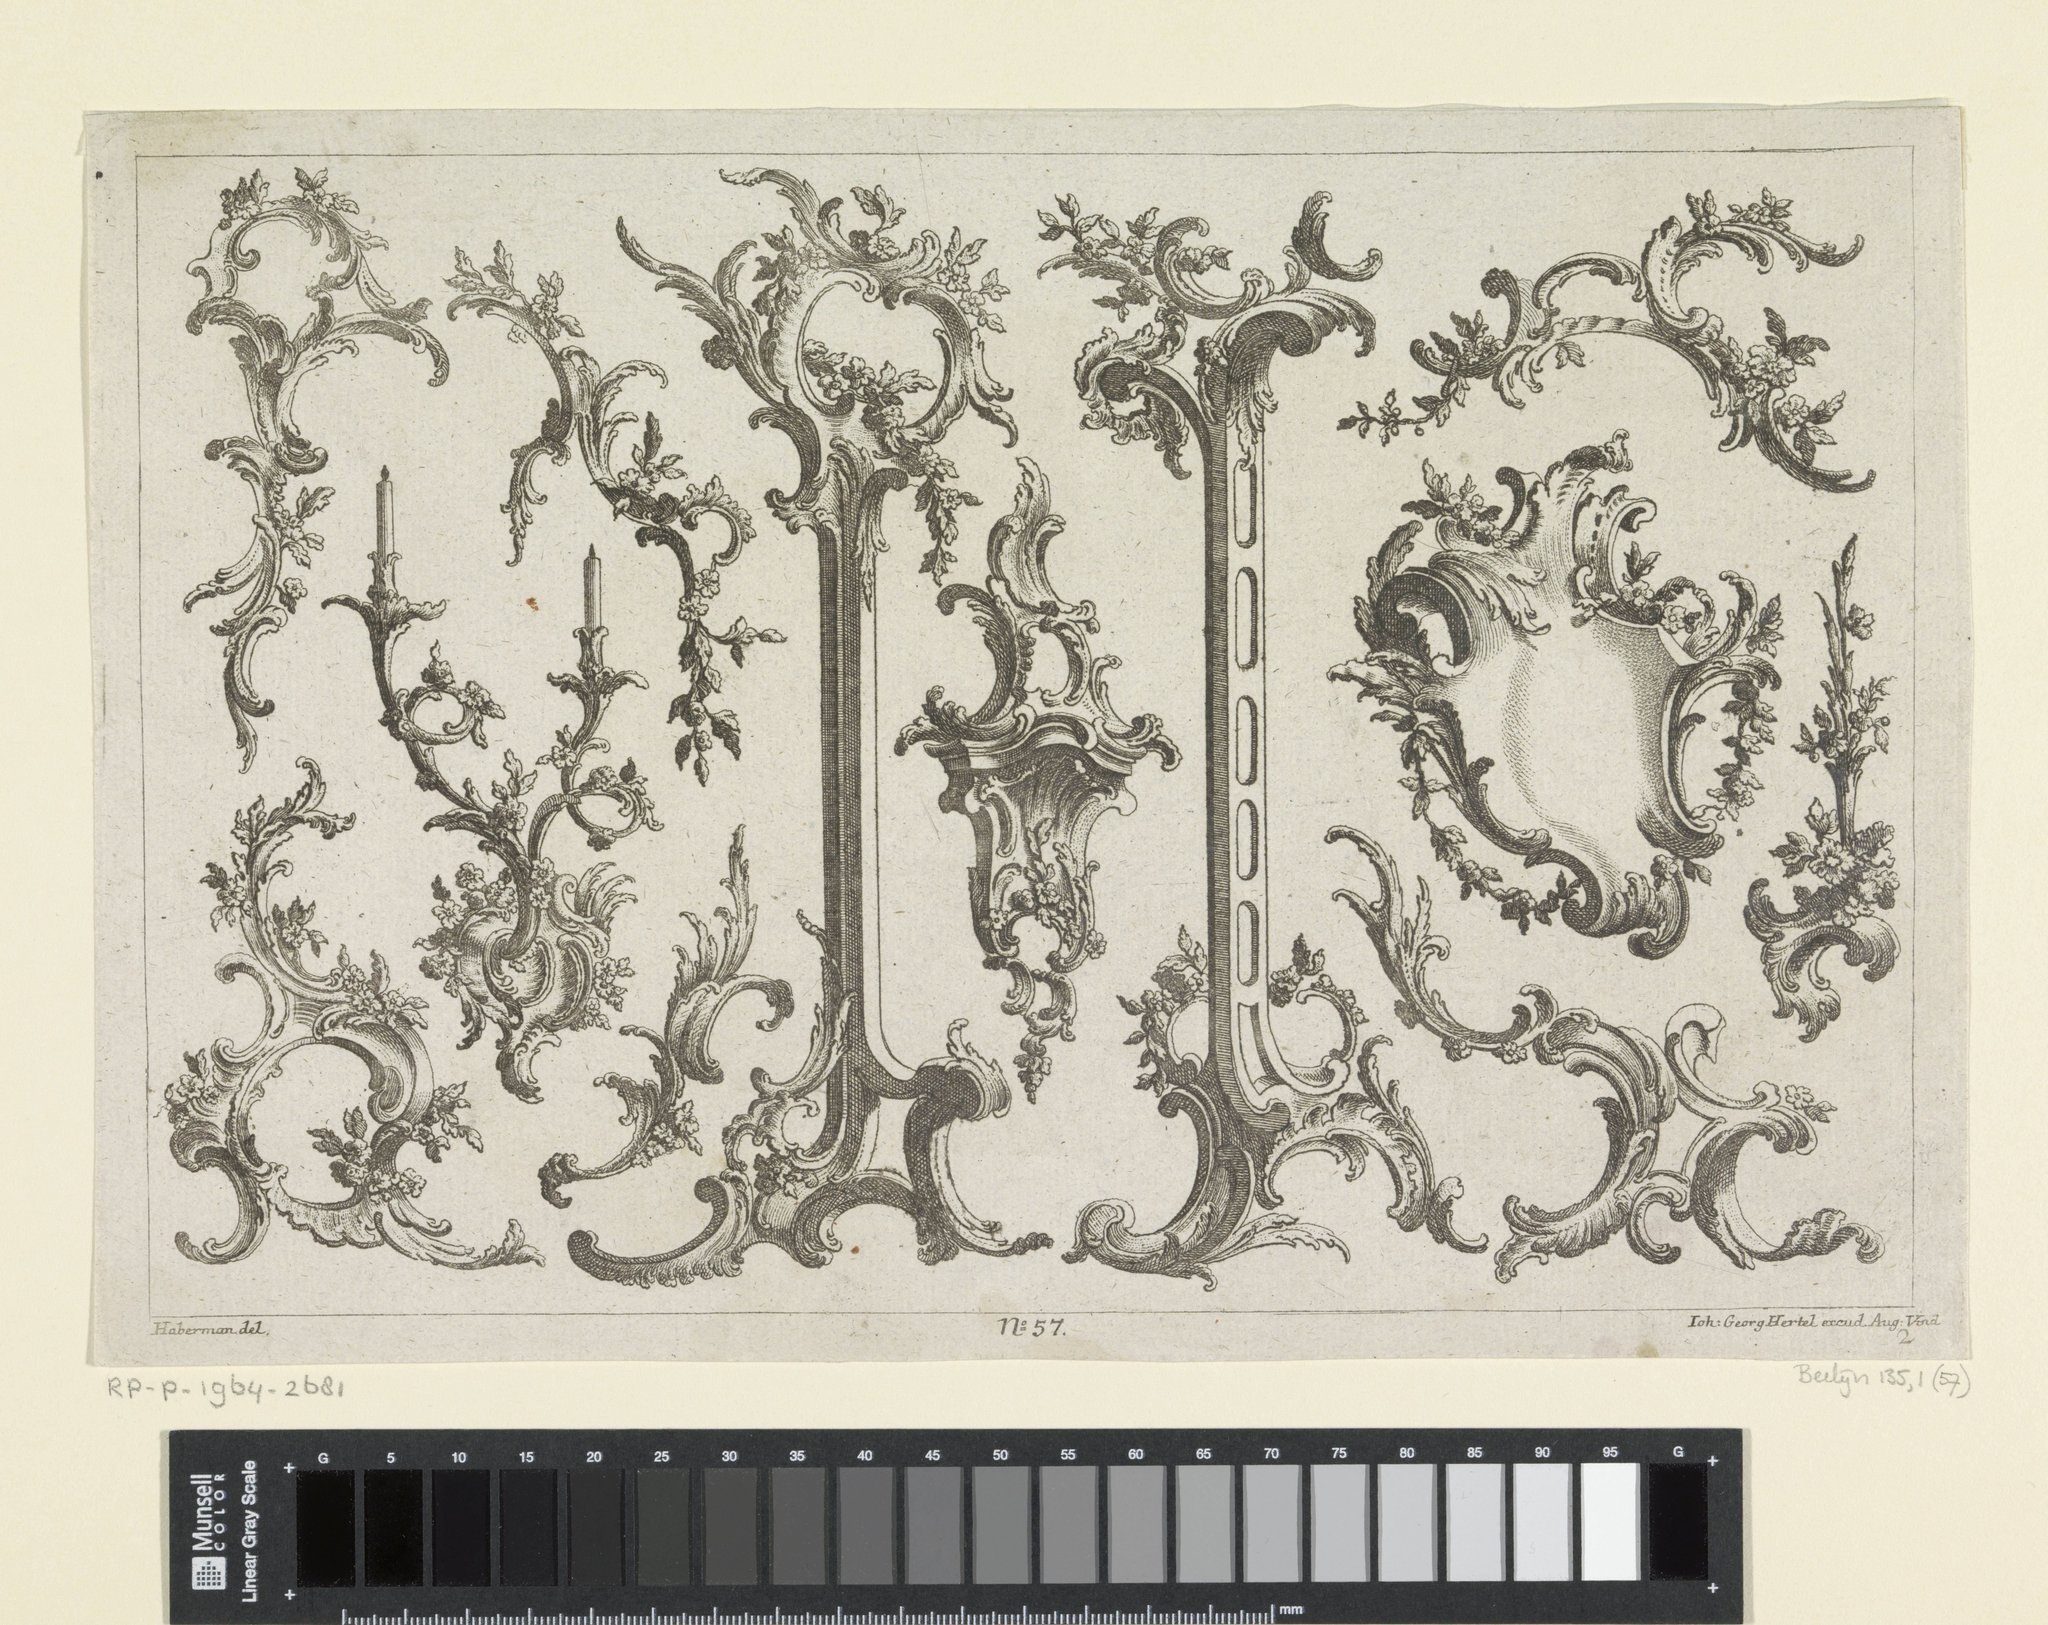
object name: print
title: Rocailles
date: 1731-1775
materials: paper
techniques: etching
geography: augsburg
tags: rocaille ornament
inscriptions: collector's mark: Lugt 2760, collector's mark: Lugt 2228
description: Rocaille ornamenten met bloemmotieven en links twee kaarsen. Uitgeversnummer 57.